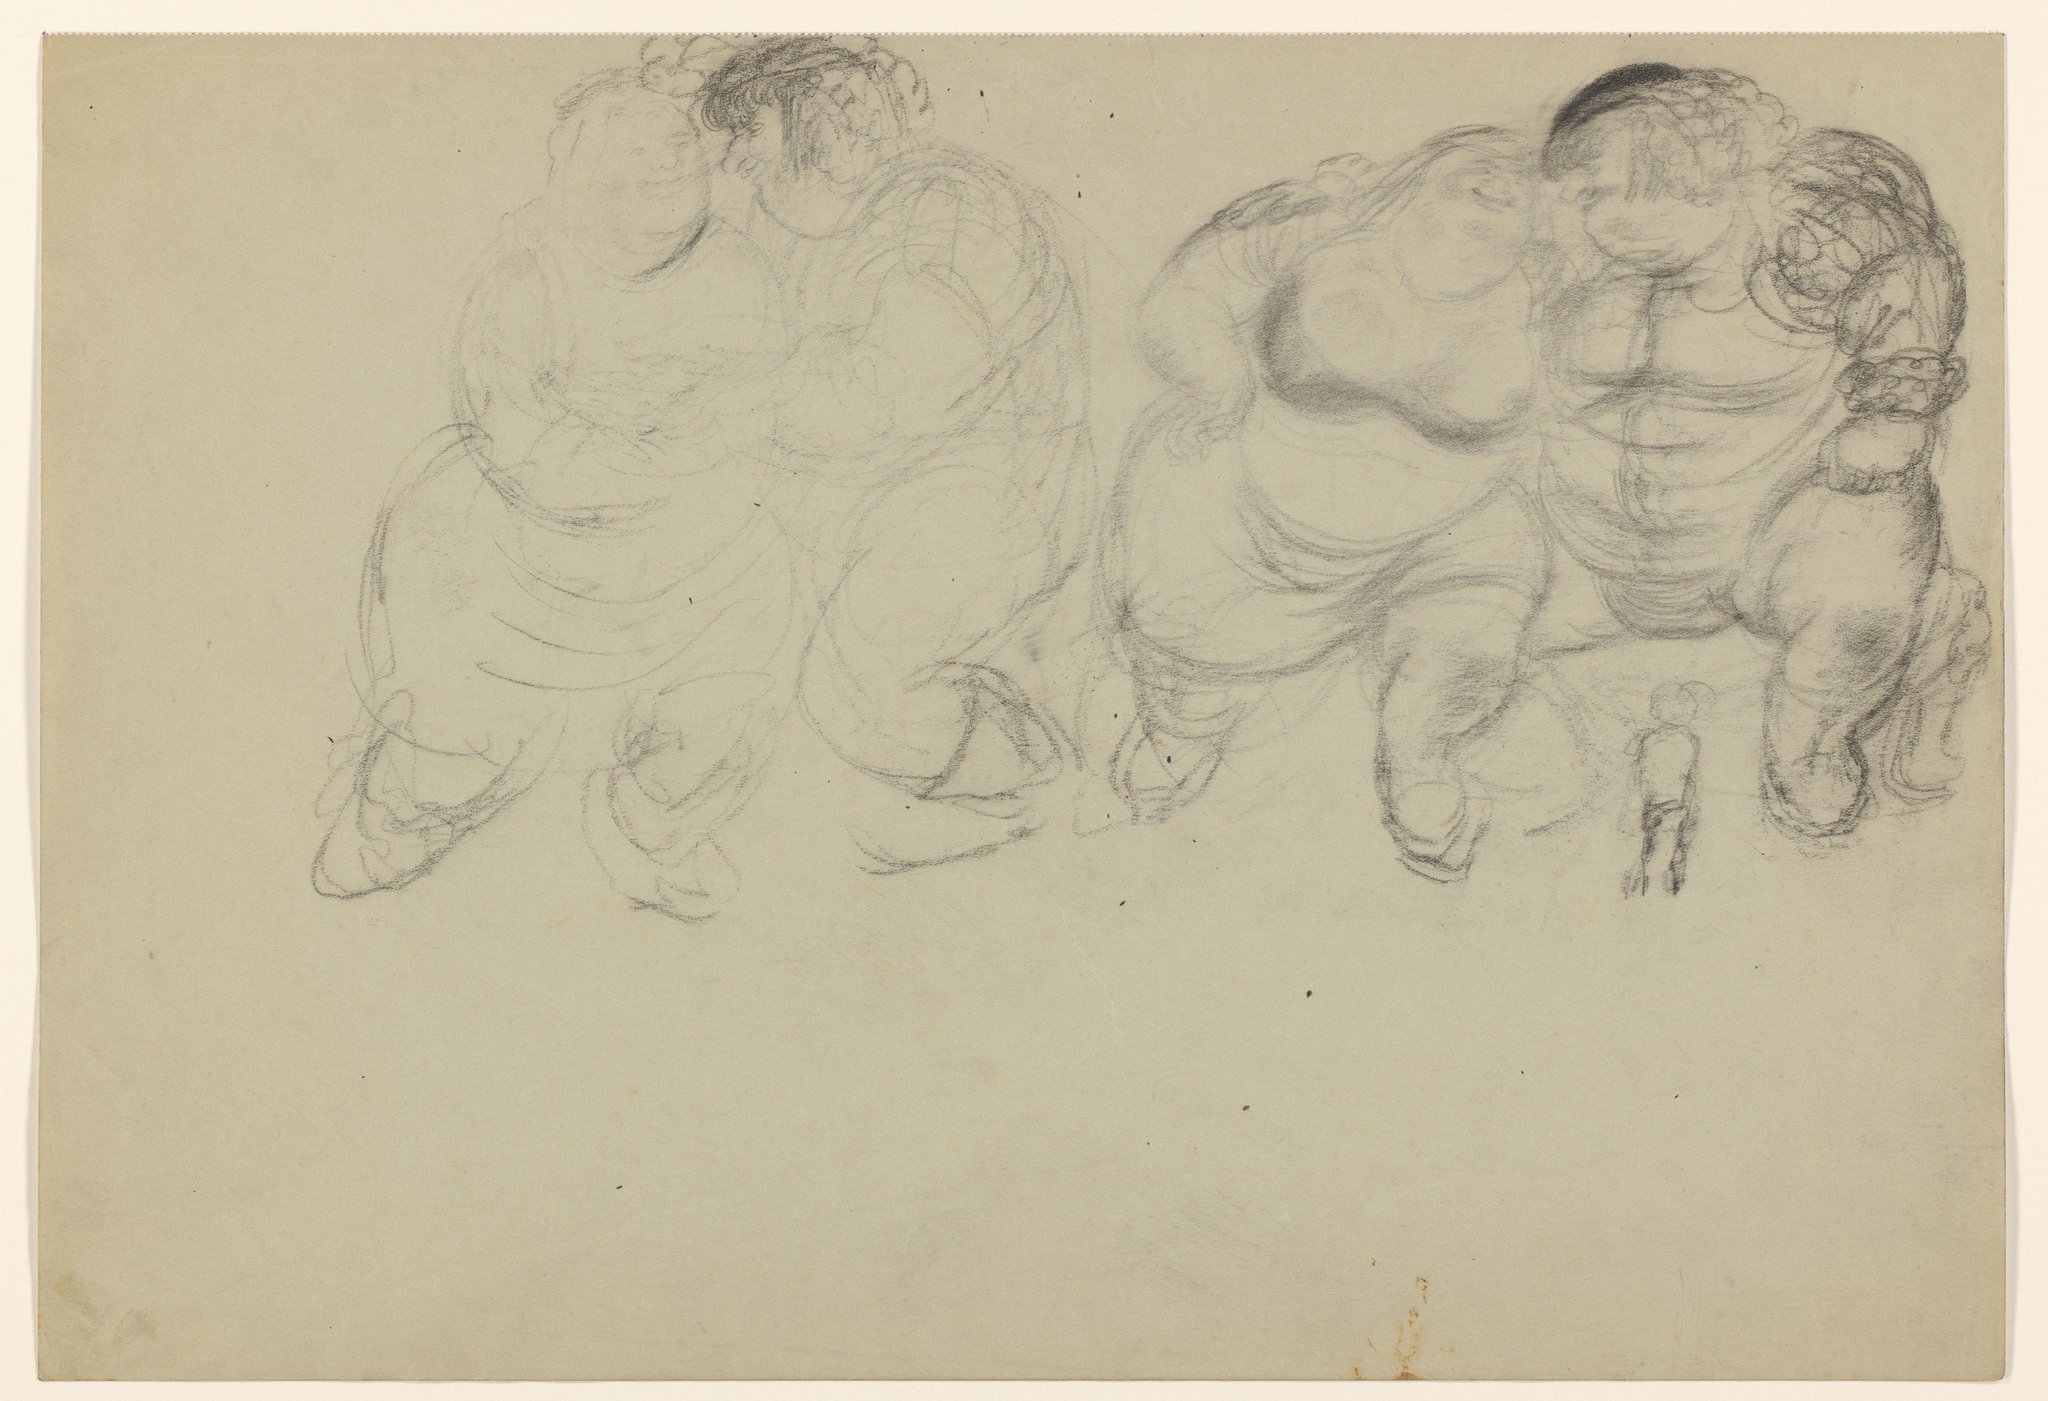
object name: drawing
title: Vier reuzen en een kleine figuur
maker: henk henriët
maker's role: draughtsman, print maker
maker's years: 1903-1945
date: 1936-1940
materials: chalk, paper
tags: giants, colossi - aa - female human figure, giants, colossi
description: Deze tekening is mogelijk een ontwerp voor een illustratie bij het boek 'Gargantua en Pantagruel' van François Rabelais.